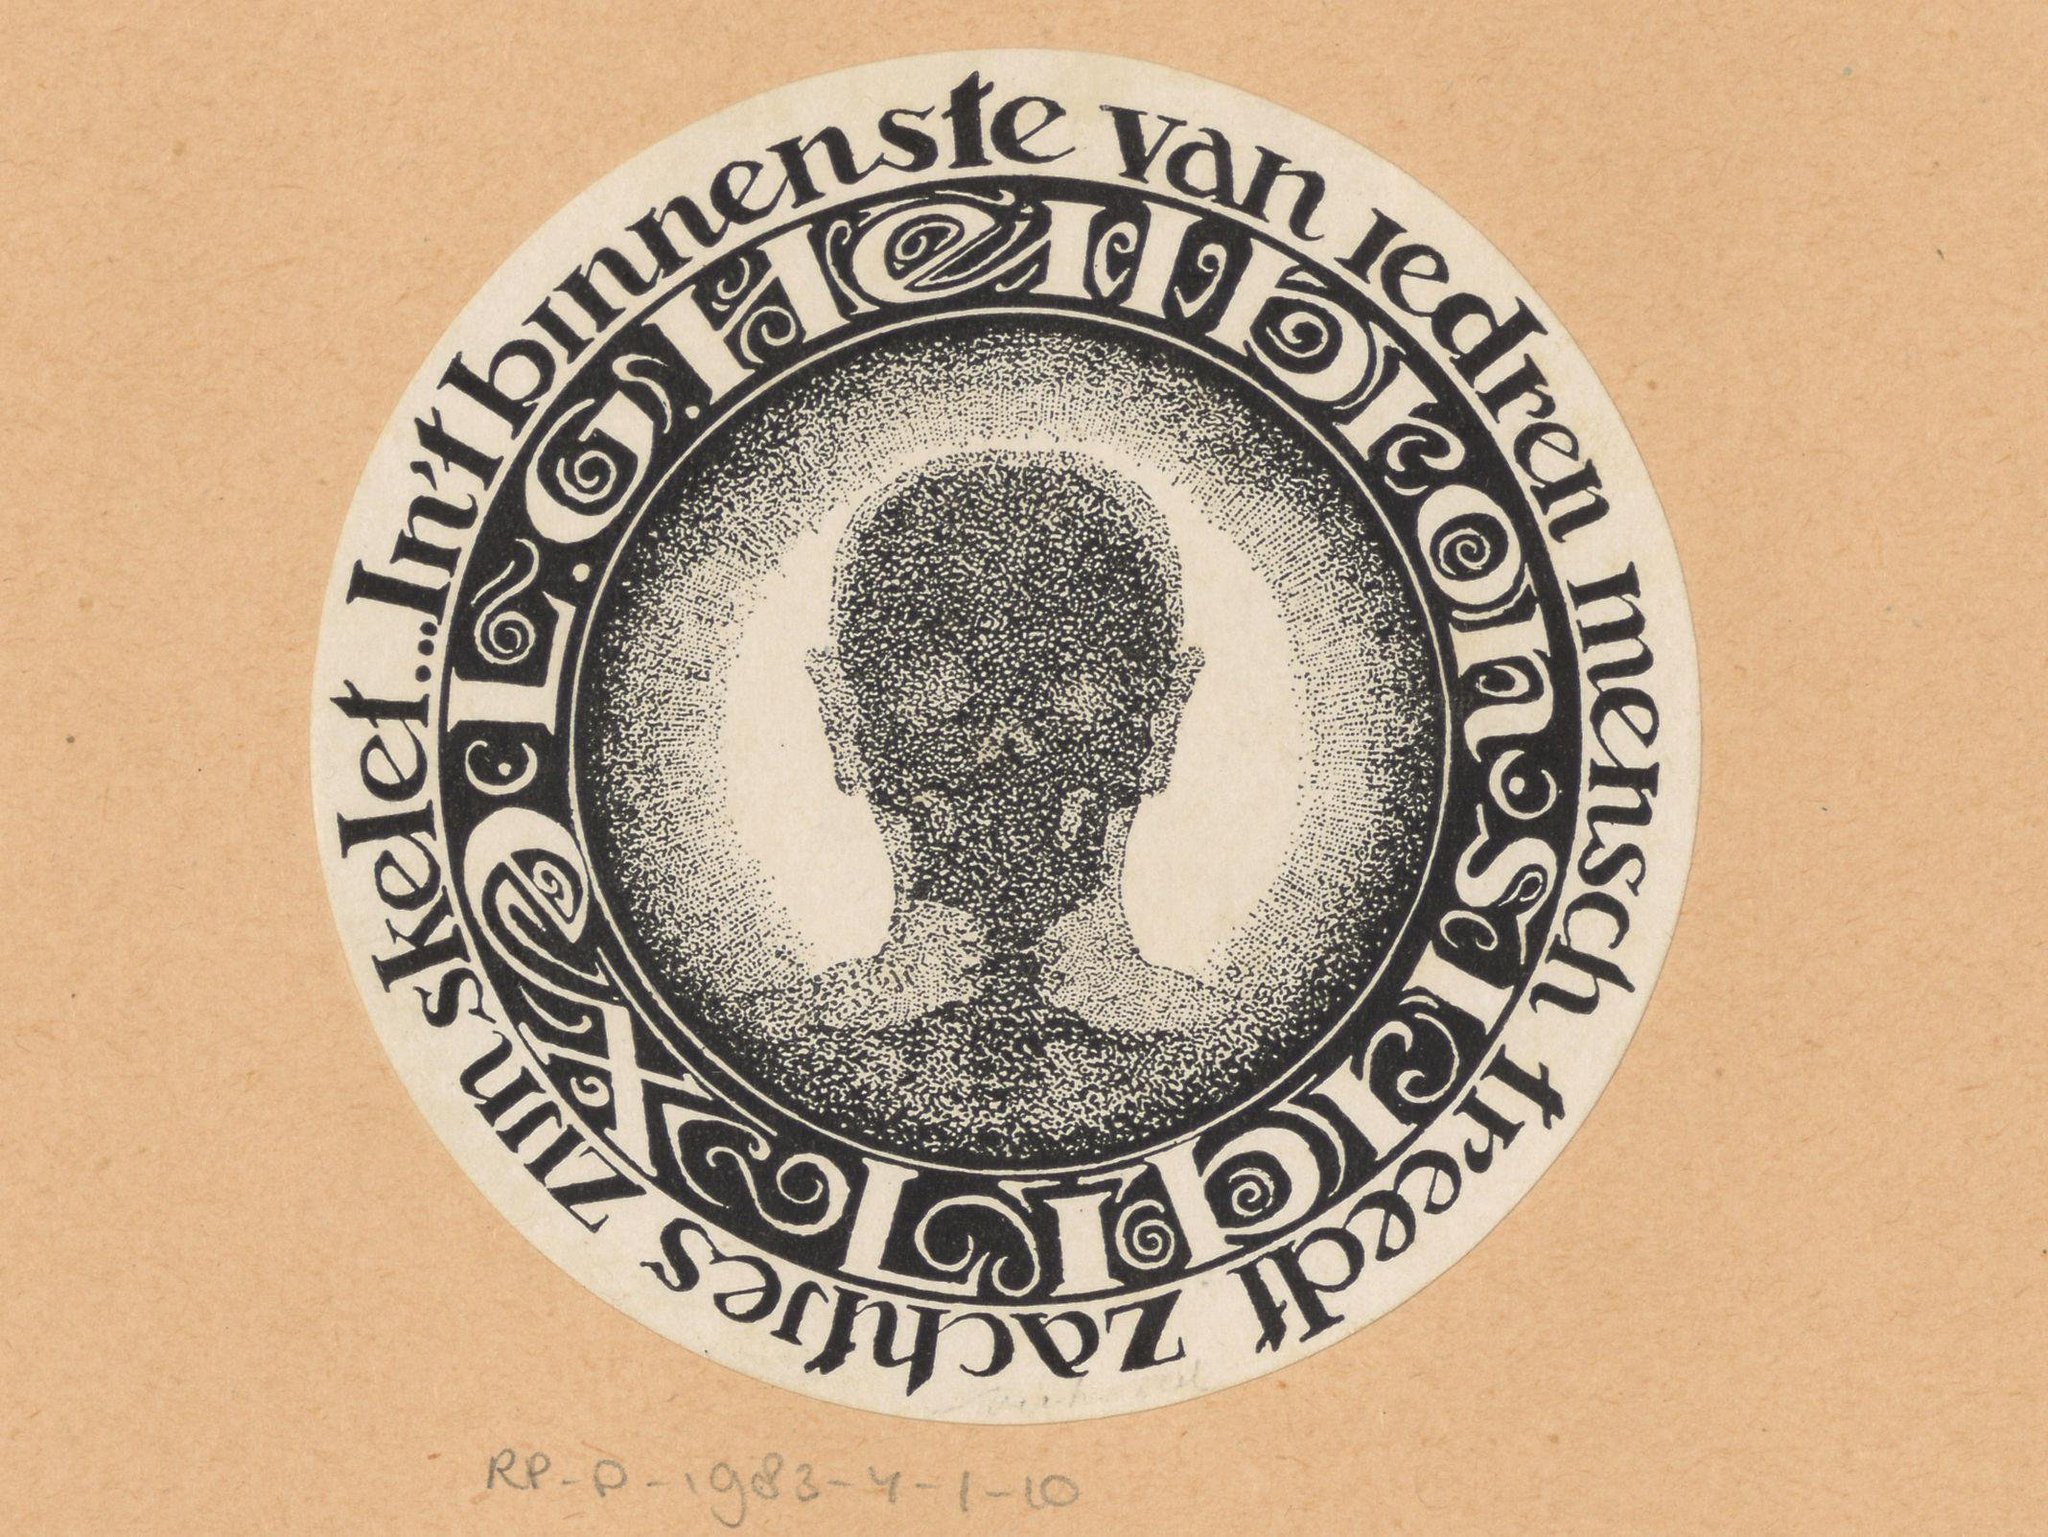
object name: bookplate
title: In 't binnenste van iedren mensch treedt zachtjes zijn skelet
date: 1920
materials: paper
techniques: printing block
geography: netherlands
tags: head (human), (human) skeleton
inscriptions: inscription: ‘Clichédruk 1920. Bestemd (...) illustratie no. 200.’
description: Het randschrift is ontleend aan "De paradijsvloek" van Alphons Laudy. De opdrachtgever van het ex libris was röntgenoloog. Het ontwerp werd door Verhagen ingezonden voor de 6th Annual ex libris exhibition van The Bookplate Association International, mei 1930 in Los Angeles. Prent is verder opgenomen in "De vrouw en haar huis", sept. 1926, "De Nederlandsche ex libriskunst" van J. Schwencke, "De huisvrouw in Indië", januari 1935.